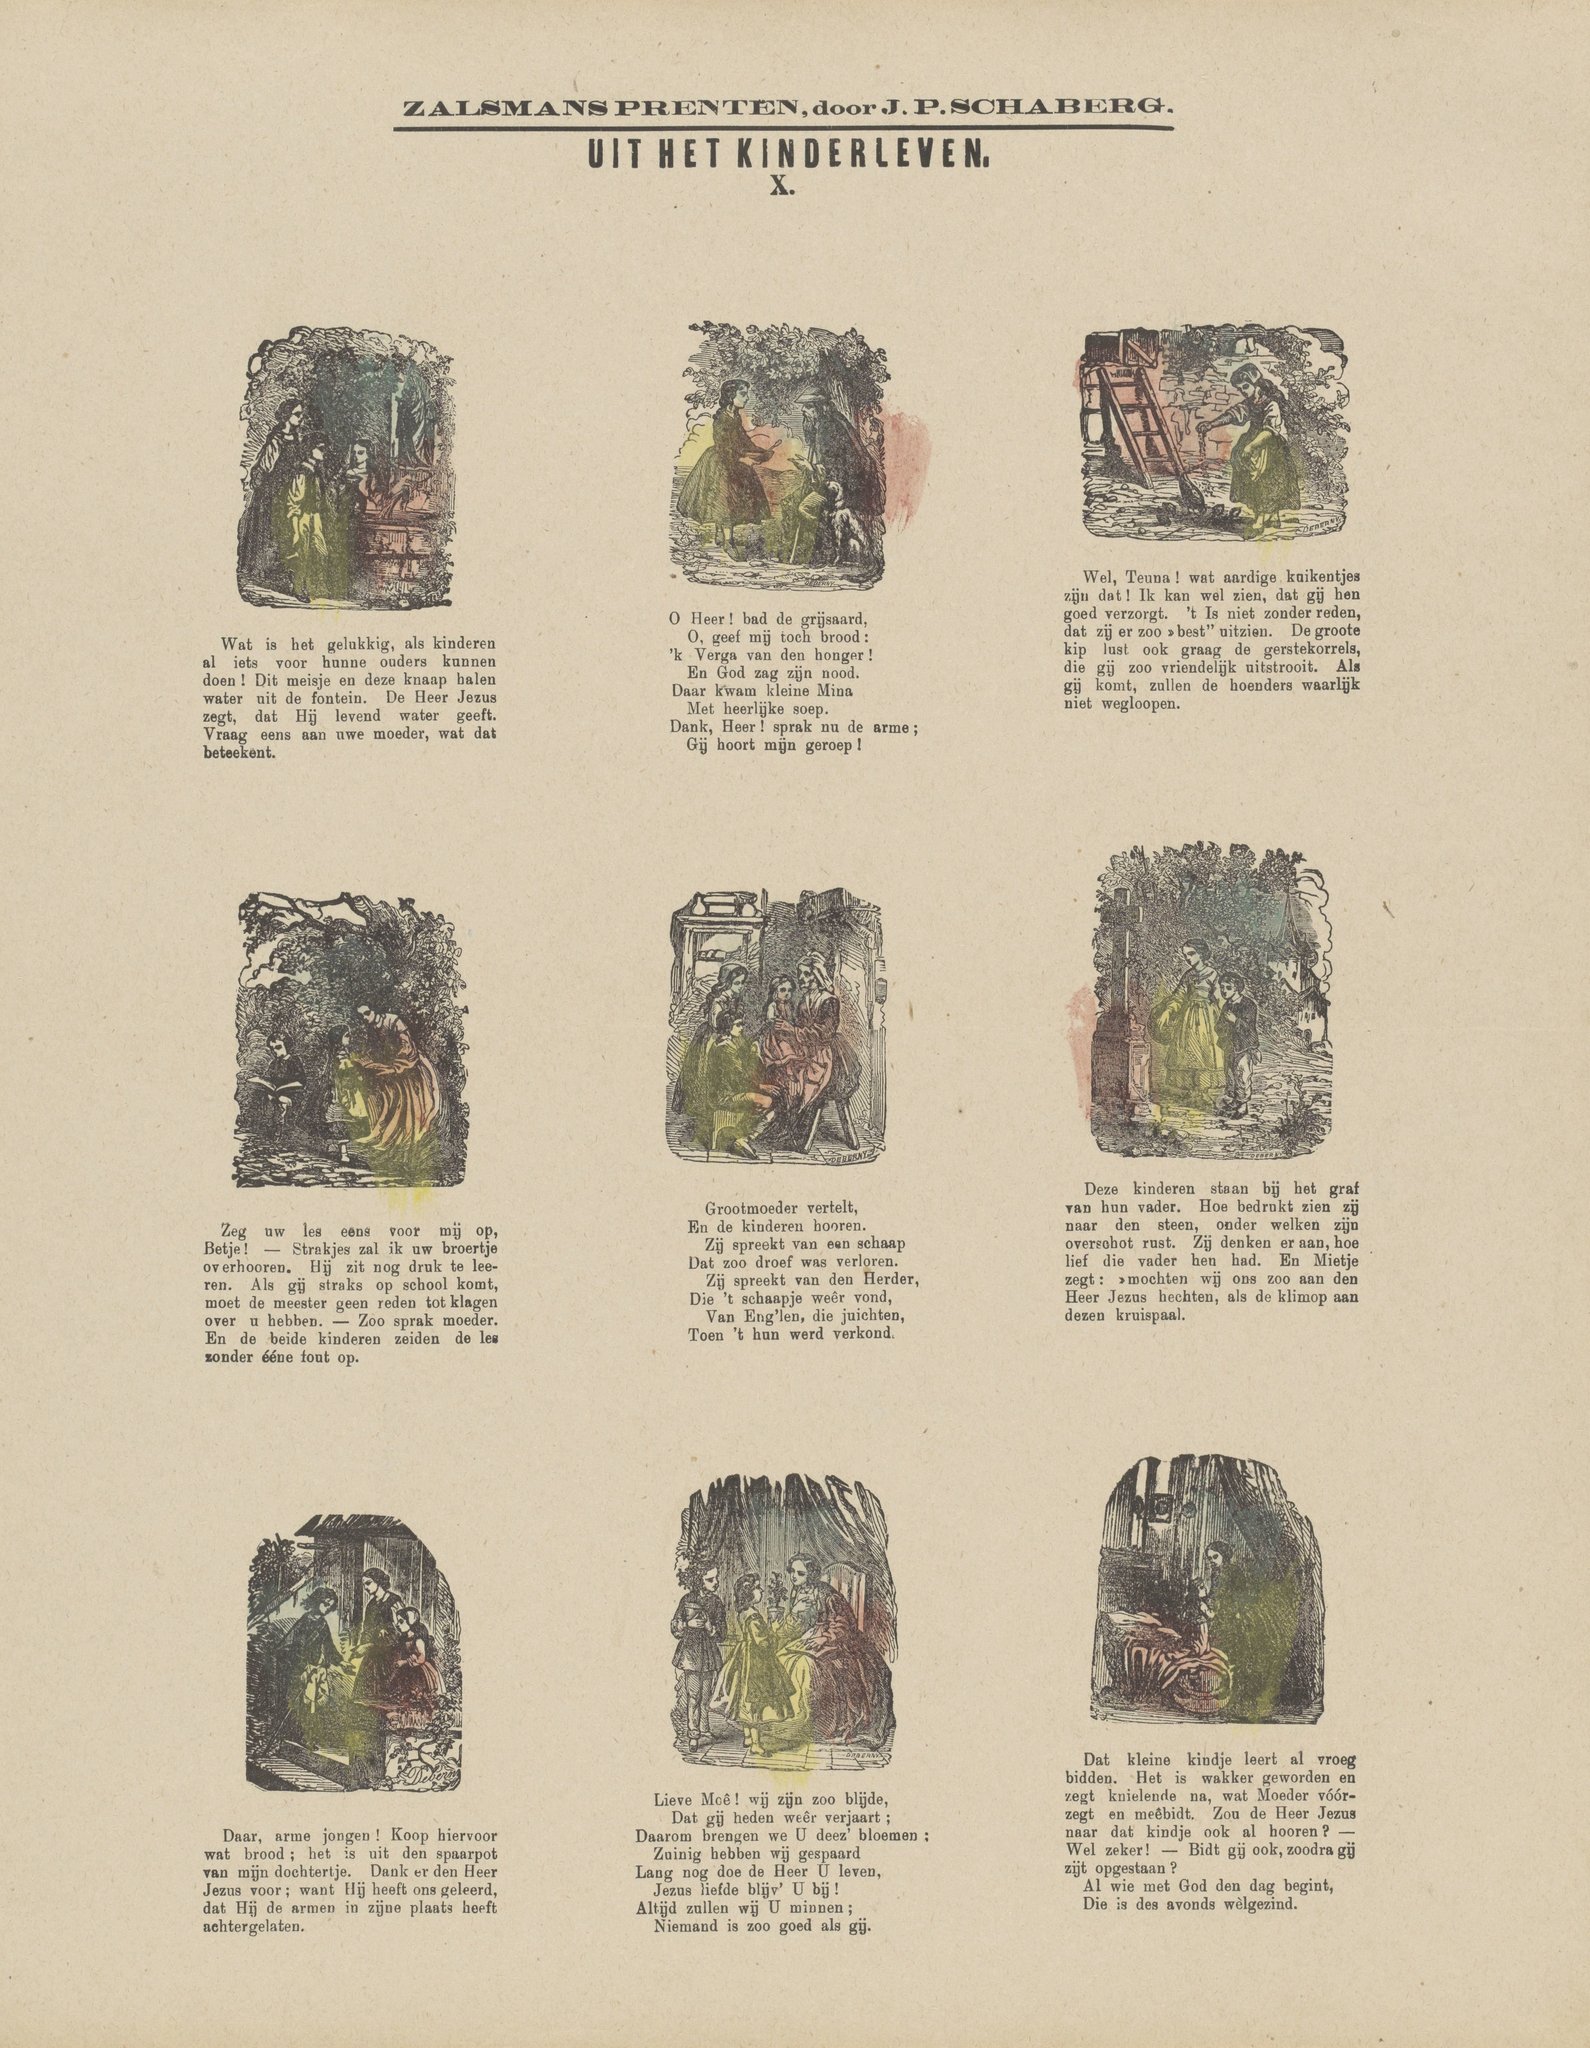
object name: popular print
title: Uit het kinderleven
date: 1869-1882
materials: paper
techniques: colour, letterpress printing, engraving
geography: europe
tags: children's games and plays, child, good behaviour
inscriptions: collector's mark: Lugt 2760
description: Blad met 9 taferelen met kinderen. Onder elke voorstelling een onderschrift. Genummerd midden boven: X.